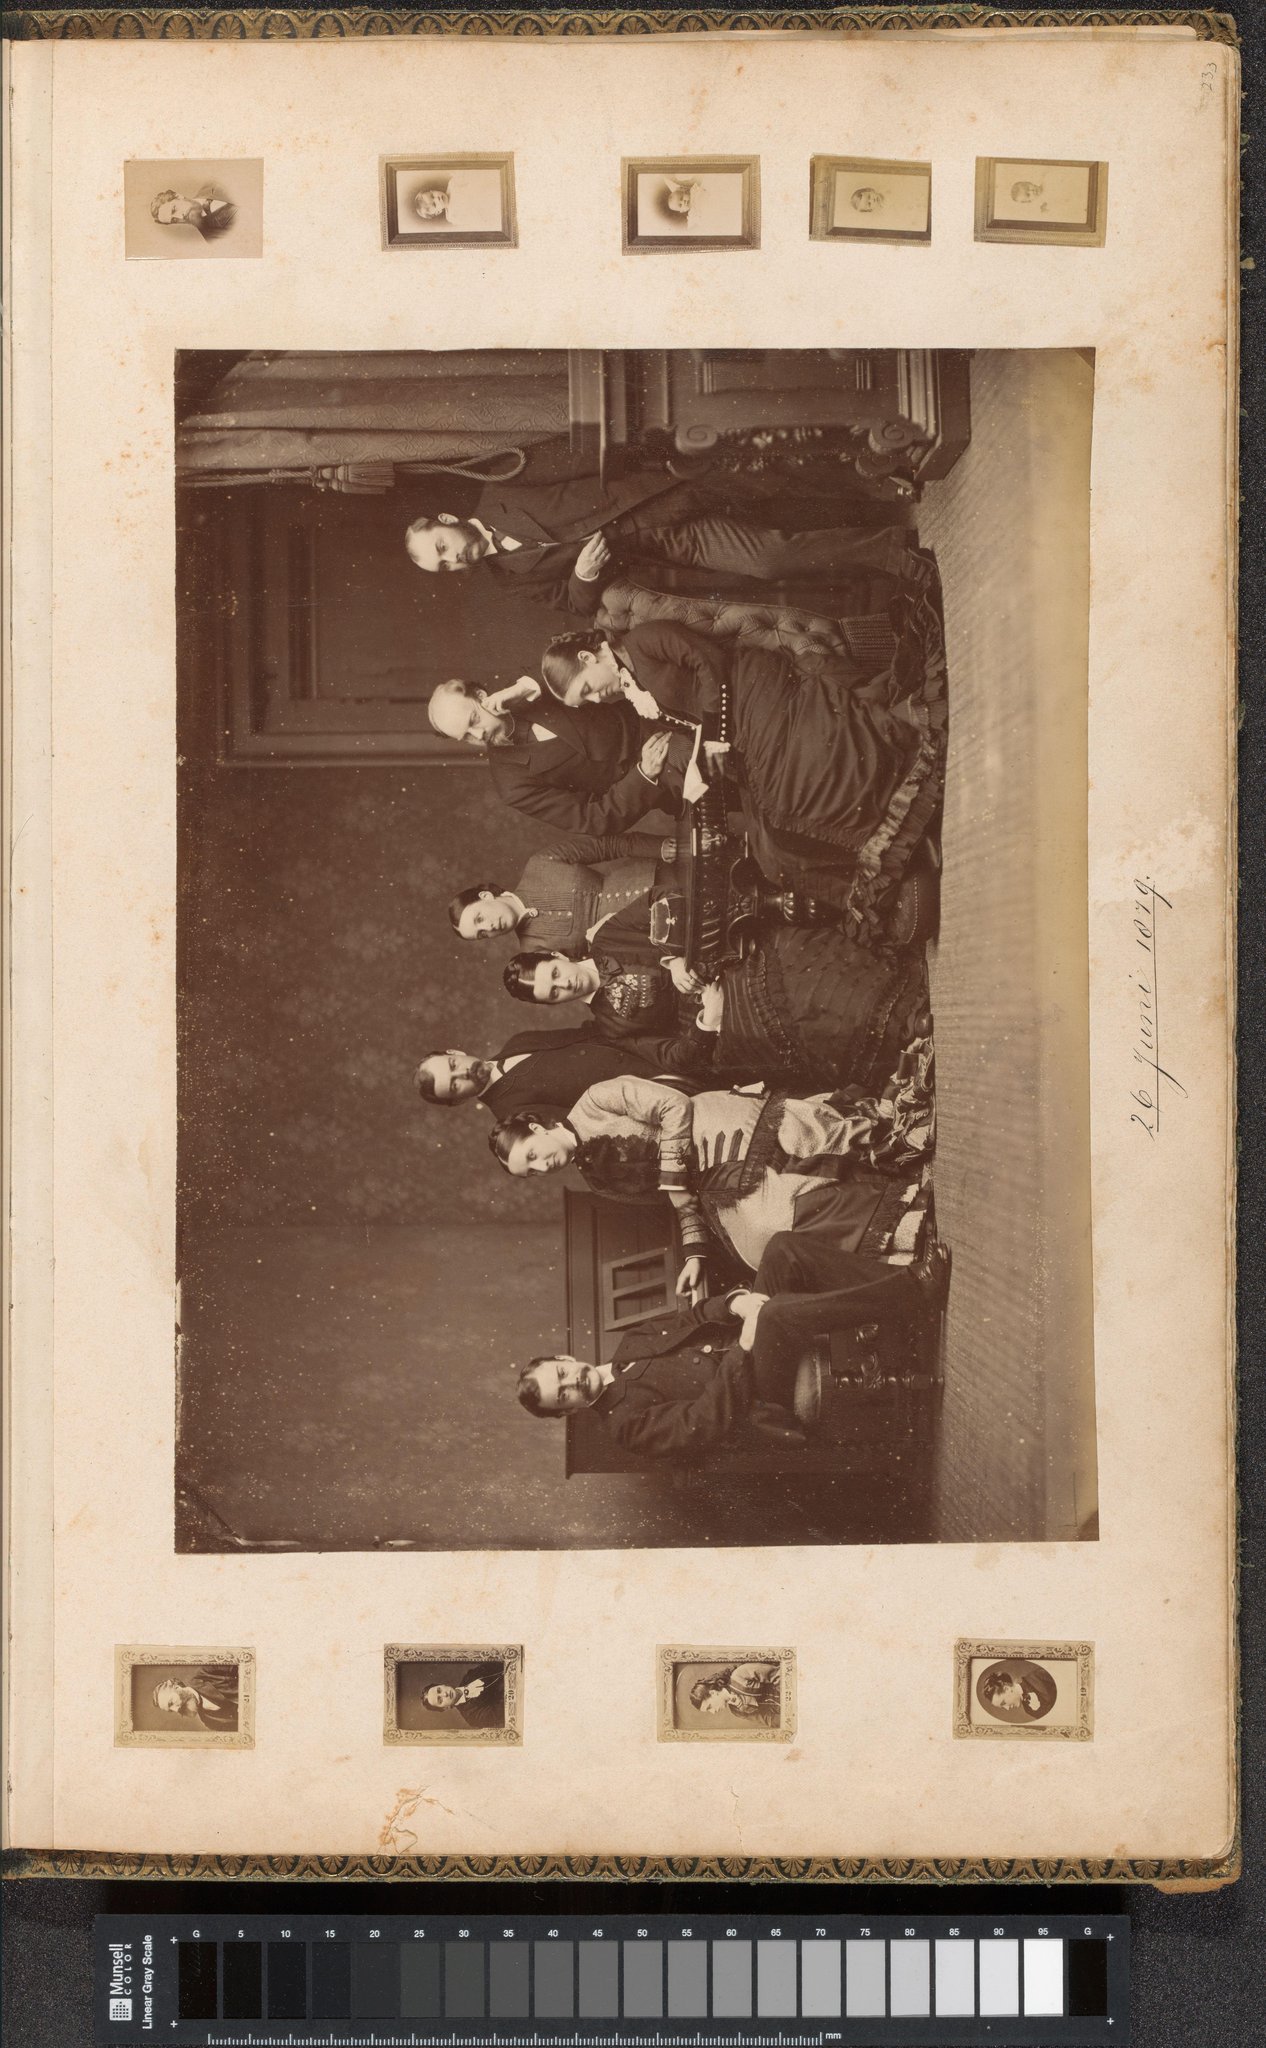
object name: photograph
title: Groepsportret van de familie Crommelin genomen ter gelegenheid van de zeventigste verjaardag van Gulian Cornelis Crommelin (1809-1891) met daar omheen kleine portretten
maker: Anonymous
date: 1879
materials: paper, photographic support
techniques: albumen print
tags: amsterdam, child, family life, brothers or sisters (second degree family relationships)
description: Op de centrale foto van links naar rechts 1. Jacob Willem Hendrik Crommelin (1844-1919, gehuwd met 4), 2. Wilhelmina Gouda (1851-1920, gehuwd met 8), 3. Robert Daniël Crommelin (1841-1907, gehuwd met 5), 4. Clara Wilhelmina Wilkens (1847-1919, gehuwd met 1), 5. Julie Elisabeth Tutein Nothenius (1853-1939, gehuwd met 3), 6. Willem Jacob Elias Crommelin (1847-1890, gehuwd met 7), 7. Hendrika de Graaf (1852-1927, gehuwd met 6) en 8. Gulian Cornelis Crommelin (1845-1905, gehuwd met 2). Aan weerszijden foto's van vermoedelijk andere leden van de familie Crommelin. Onderdeel van Fotoalbum van Robert Daniel Crommelin (1841-1907).